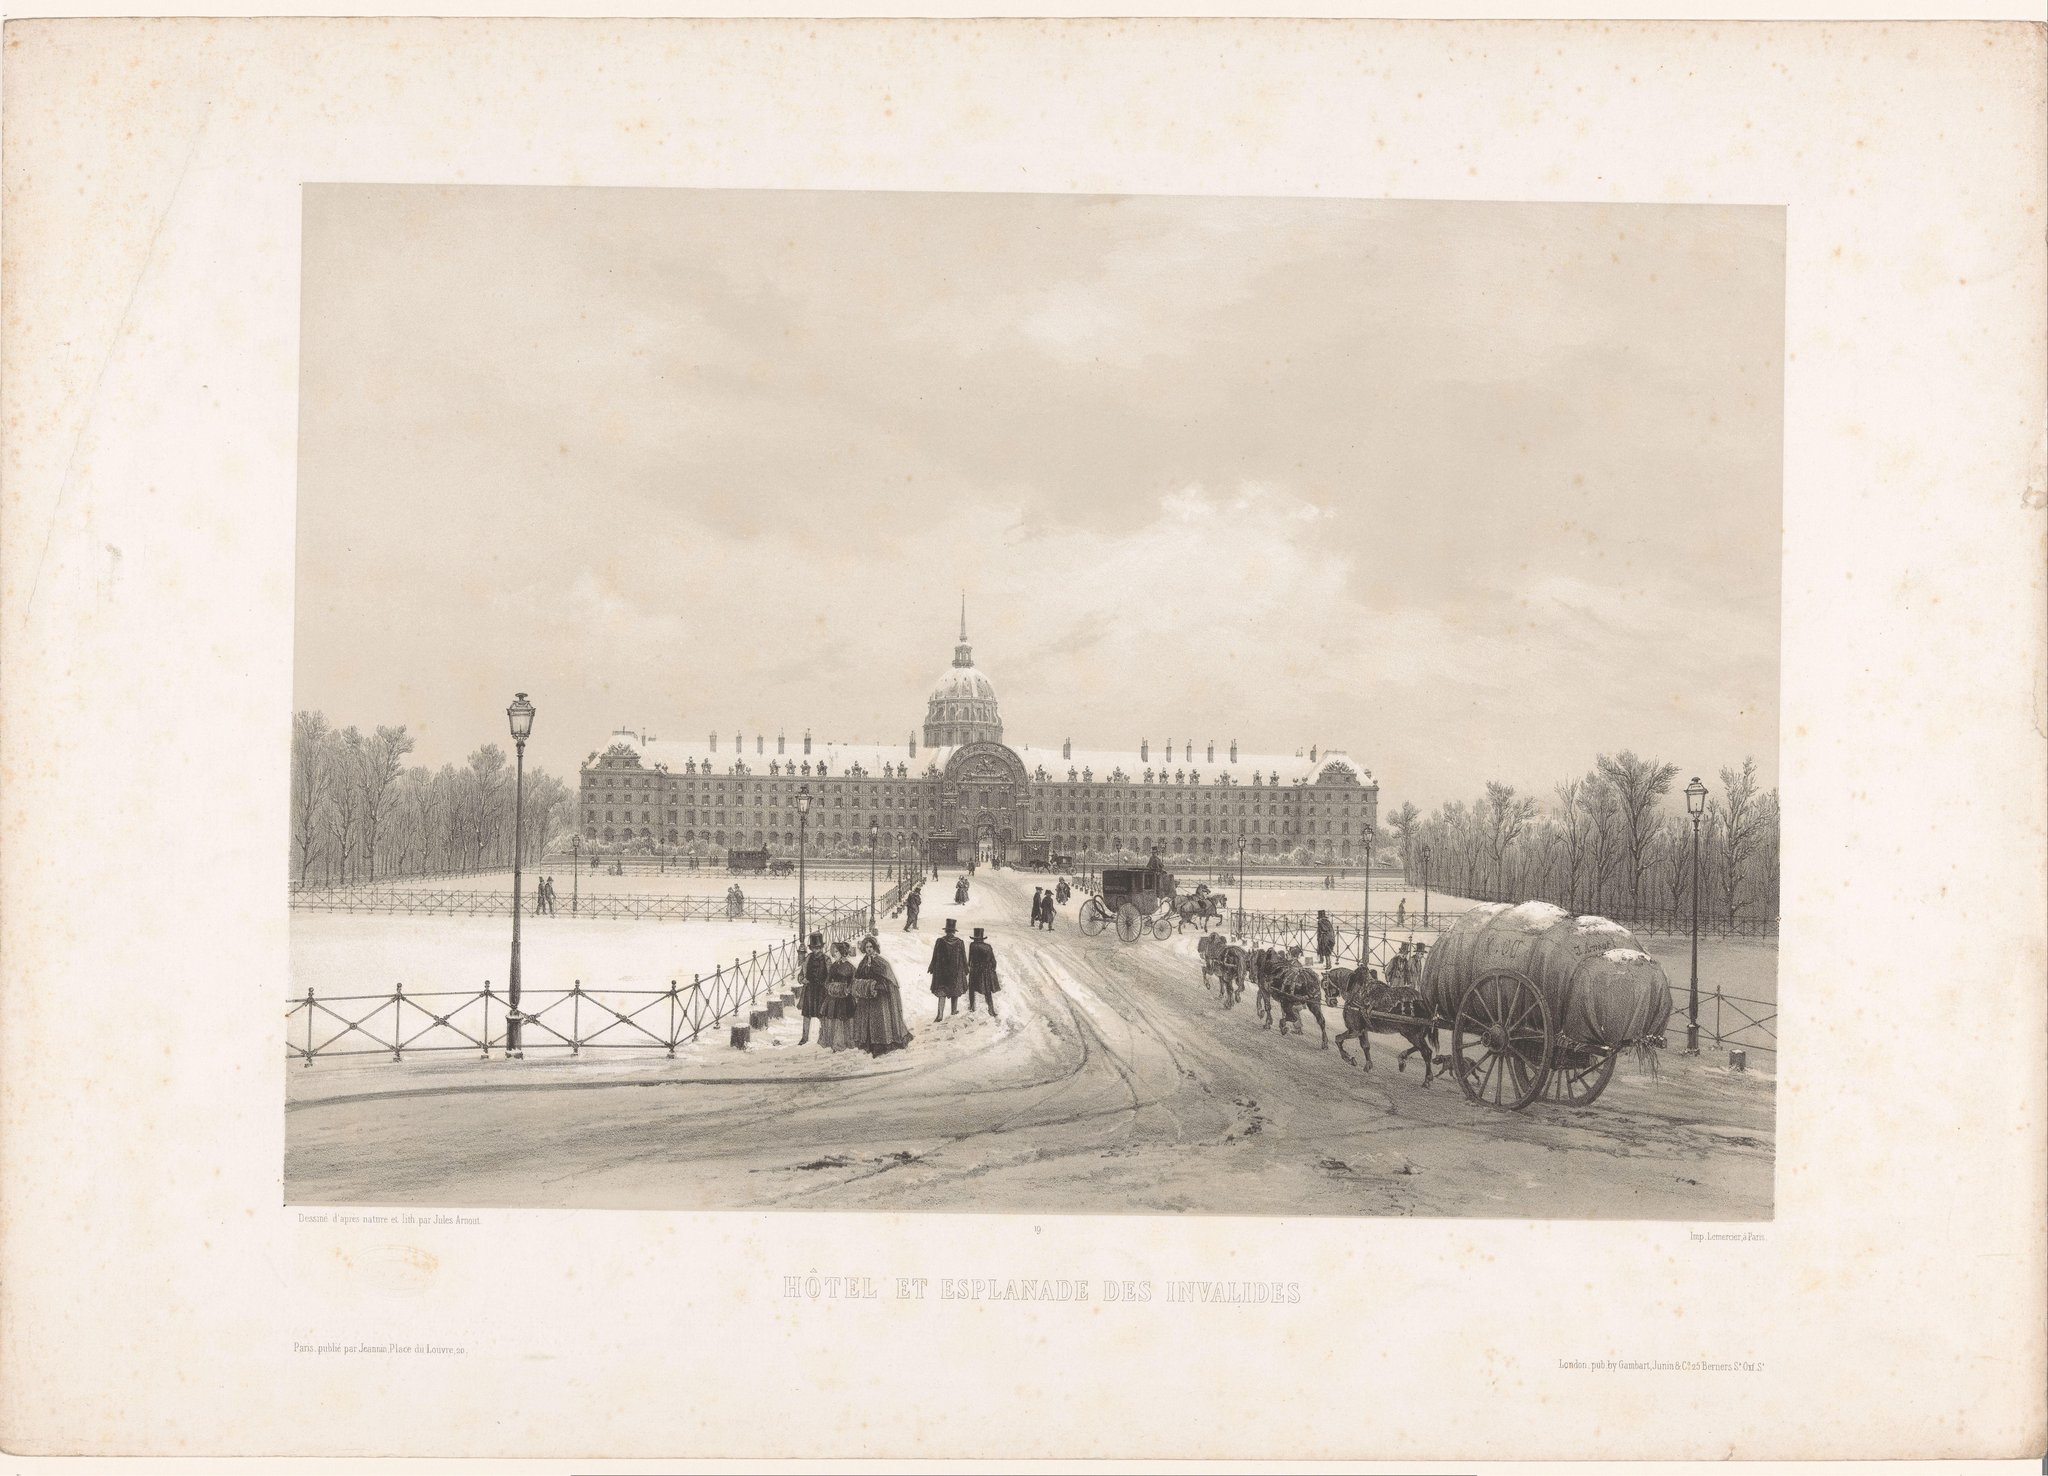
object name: print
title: Zicht op het Hôtel des Invalides en de esplanade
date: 1844-1845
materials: paper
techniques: tone lithography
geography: paris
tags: avenue, boulevard, promenade, esplanade, old-soldiers-home, 'hôtel des invalides', dome ~ architecture, paris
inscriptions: check stamp: Lugt 1397c